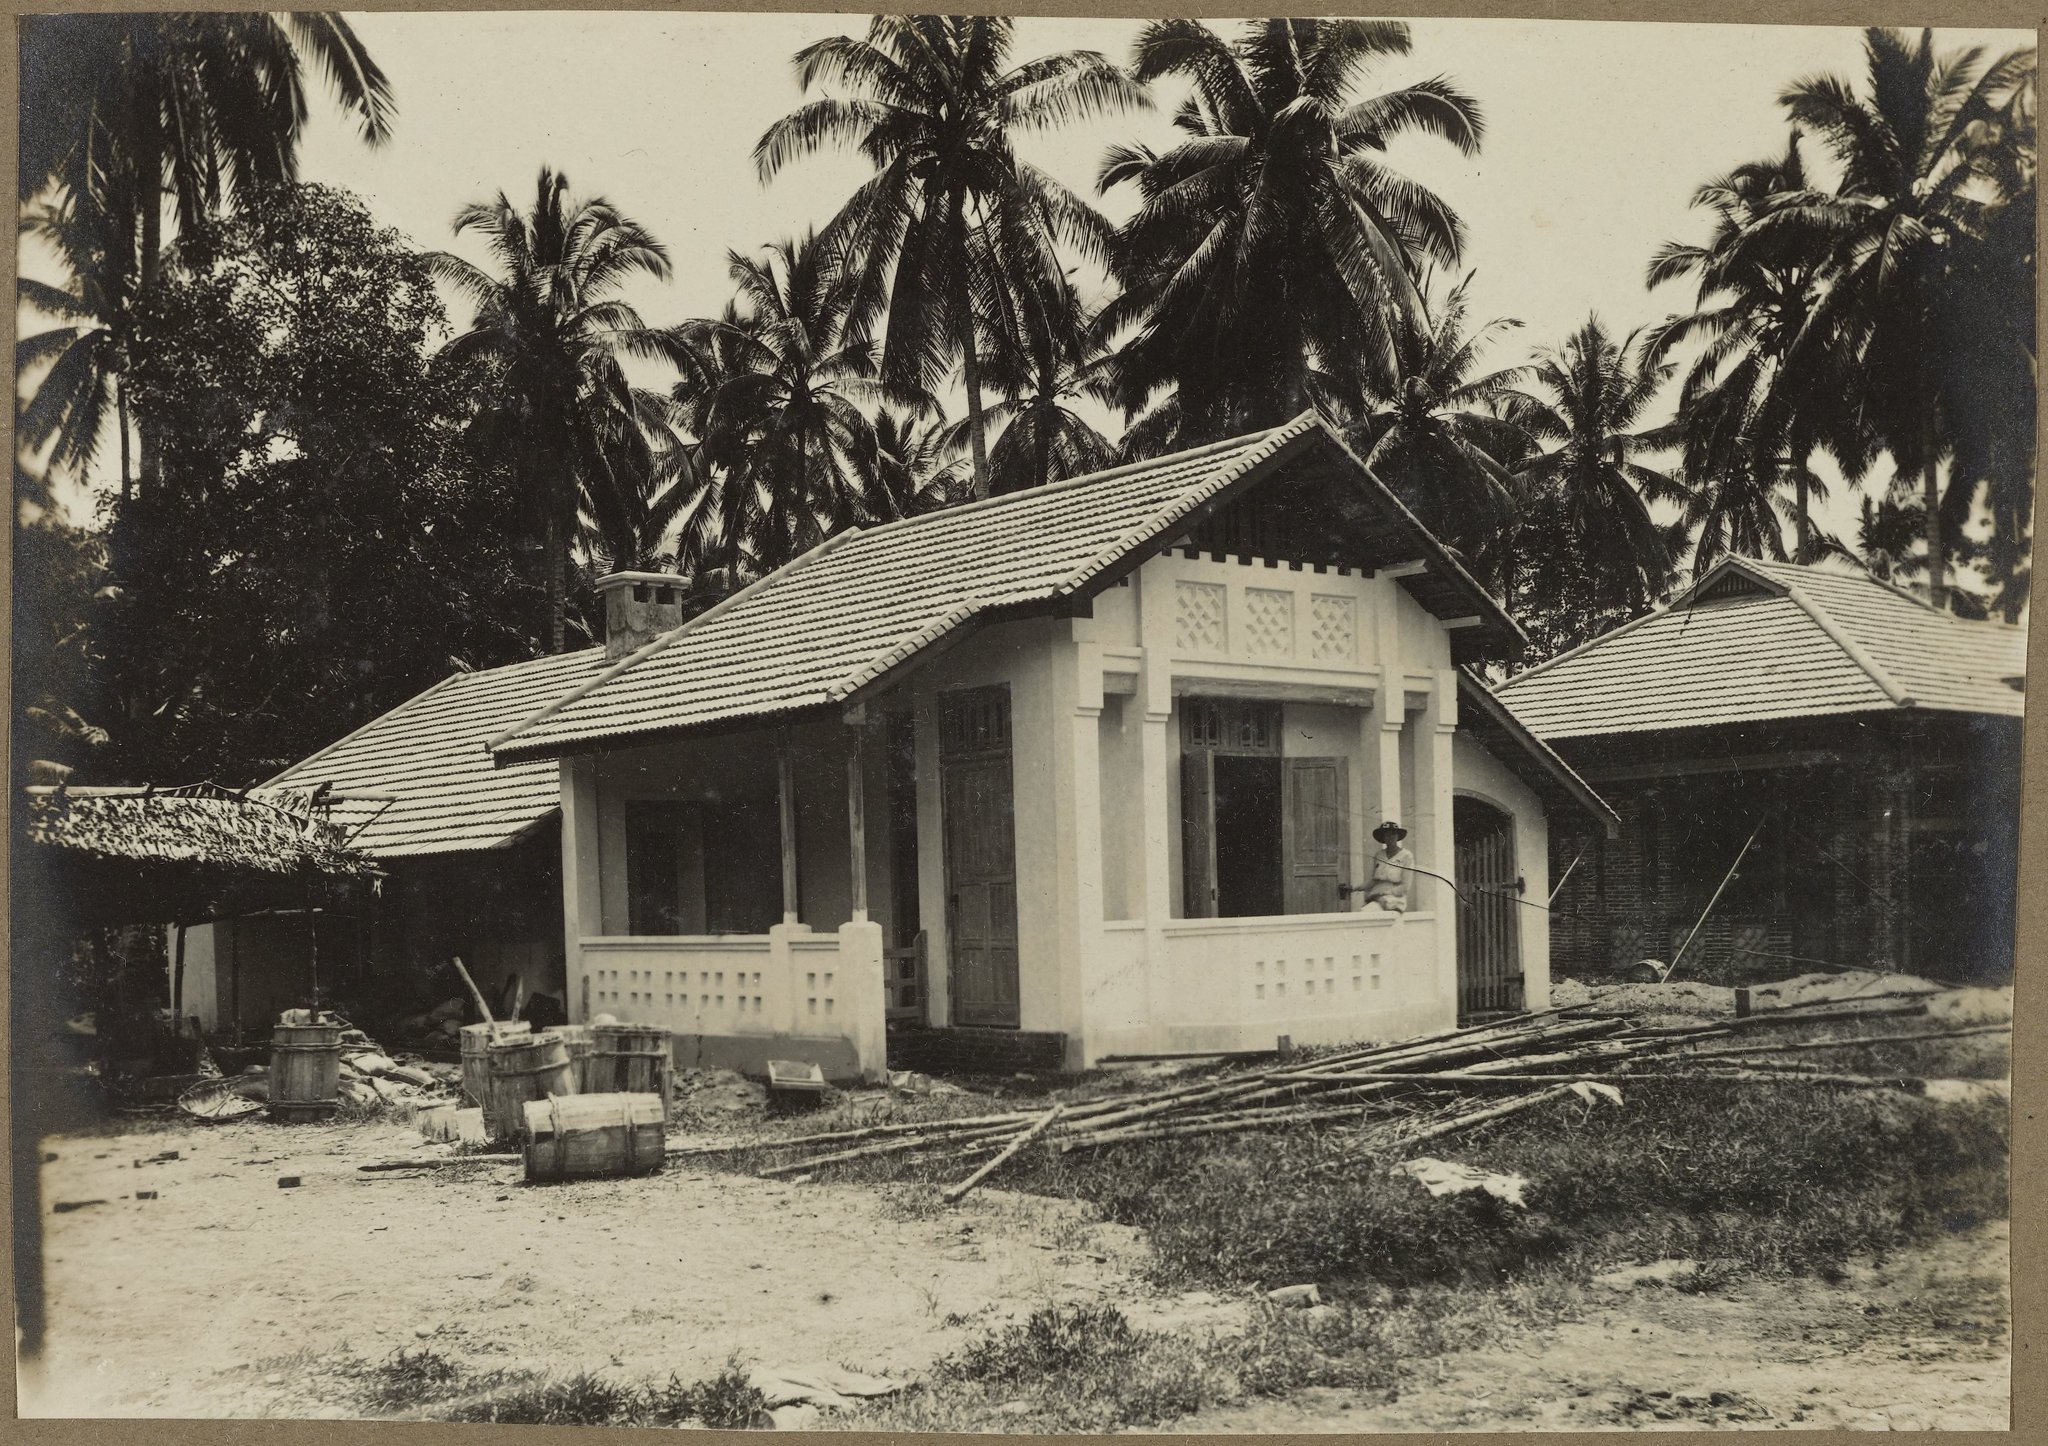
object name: photograph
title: Enkele voltooide gebouwen in een gebouwencomplex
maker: Anonymous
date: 1914-1919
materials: photographic support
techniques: gelatin silver print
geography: medan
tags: detached house in city, representation of real building (either existing or having existed), architecture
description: Enkele voltooide gebouwen op een bouwterrein met een groep gebouwen, waarschijnlijk te Medan. Foto in het fotoalbum van het Nederlandse architectenbureau en aannemersbedrijf Bennink en Riphagen te Medan in de jaren ca. 1914-1919.